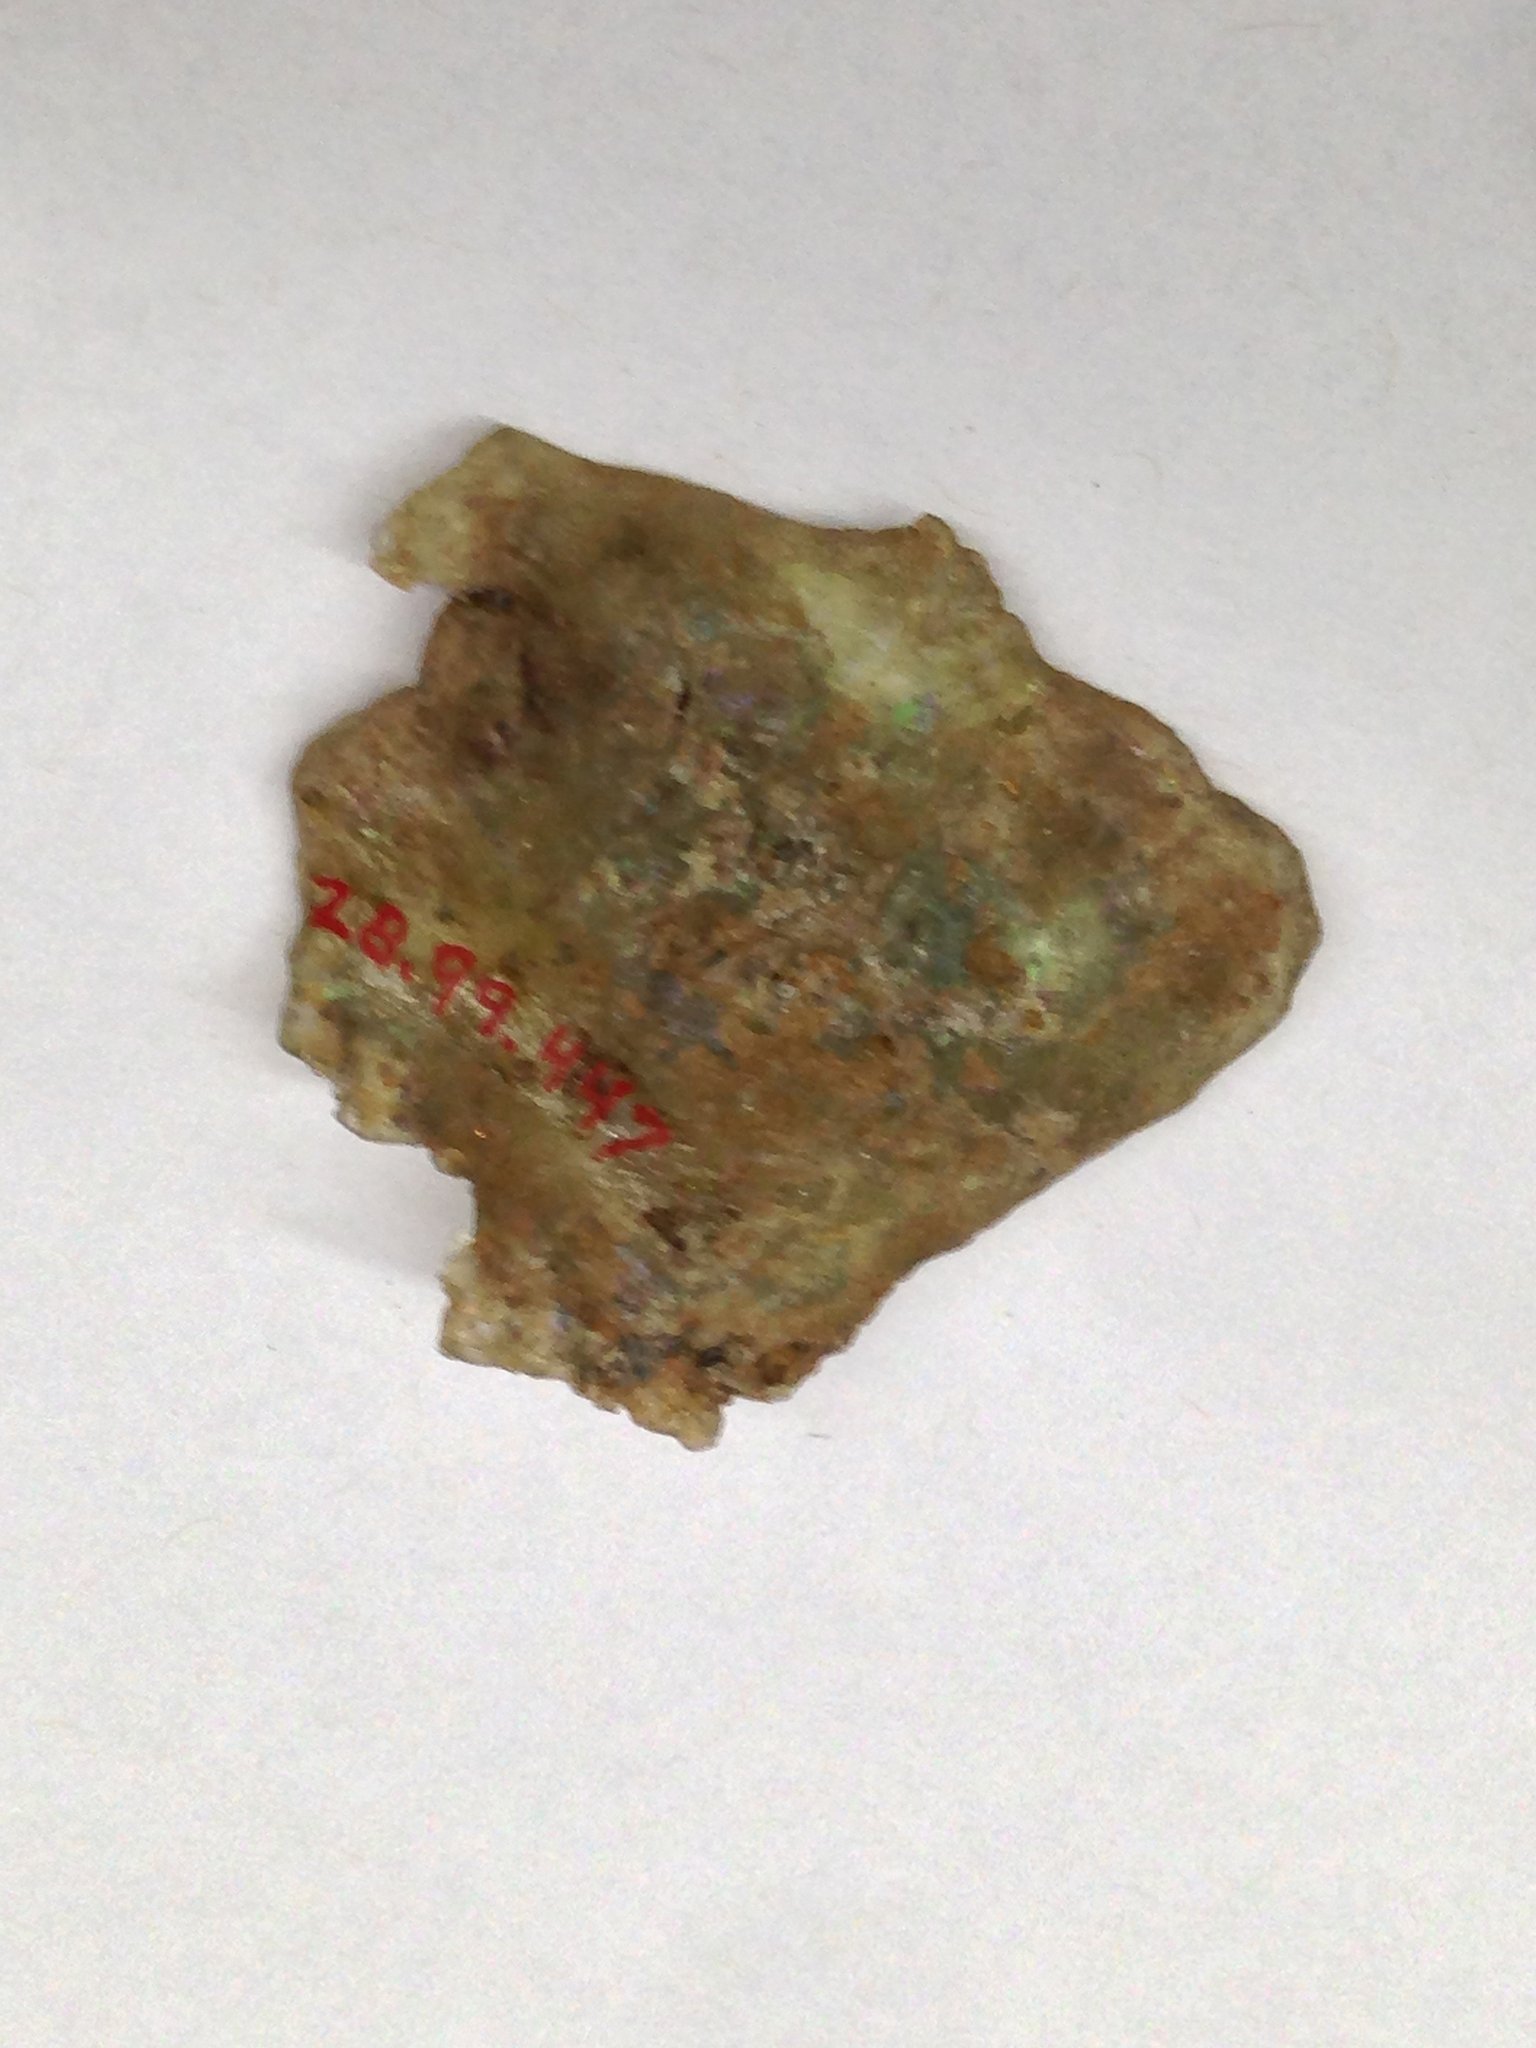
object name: fragment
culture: european or middle eastern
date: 1150-1250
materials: ceramic, glass